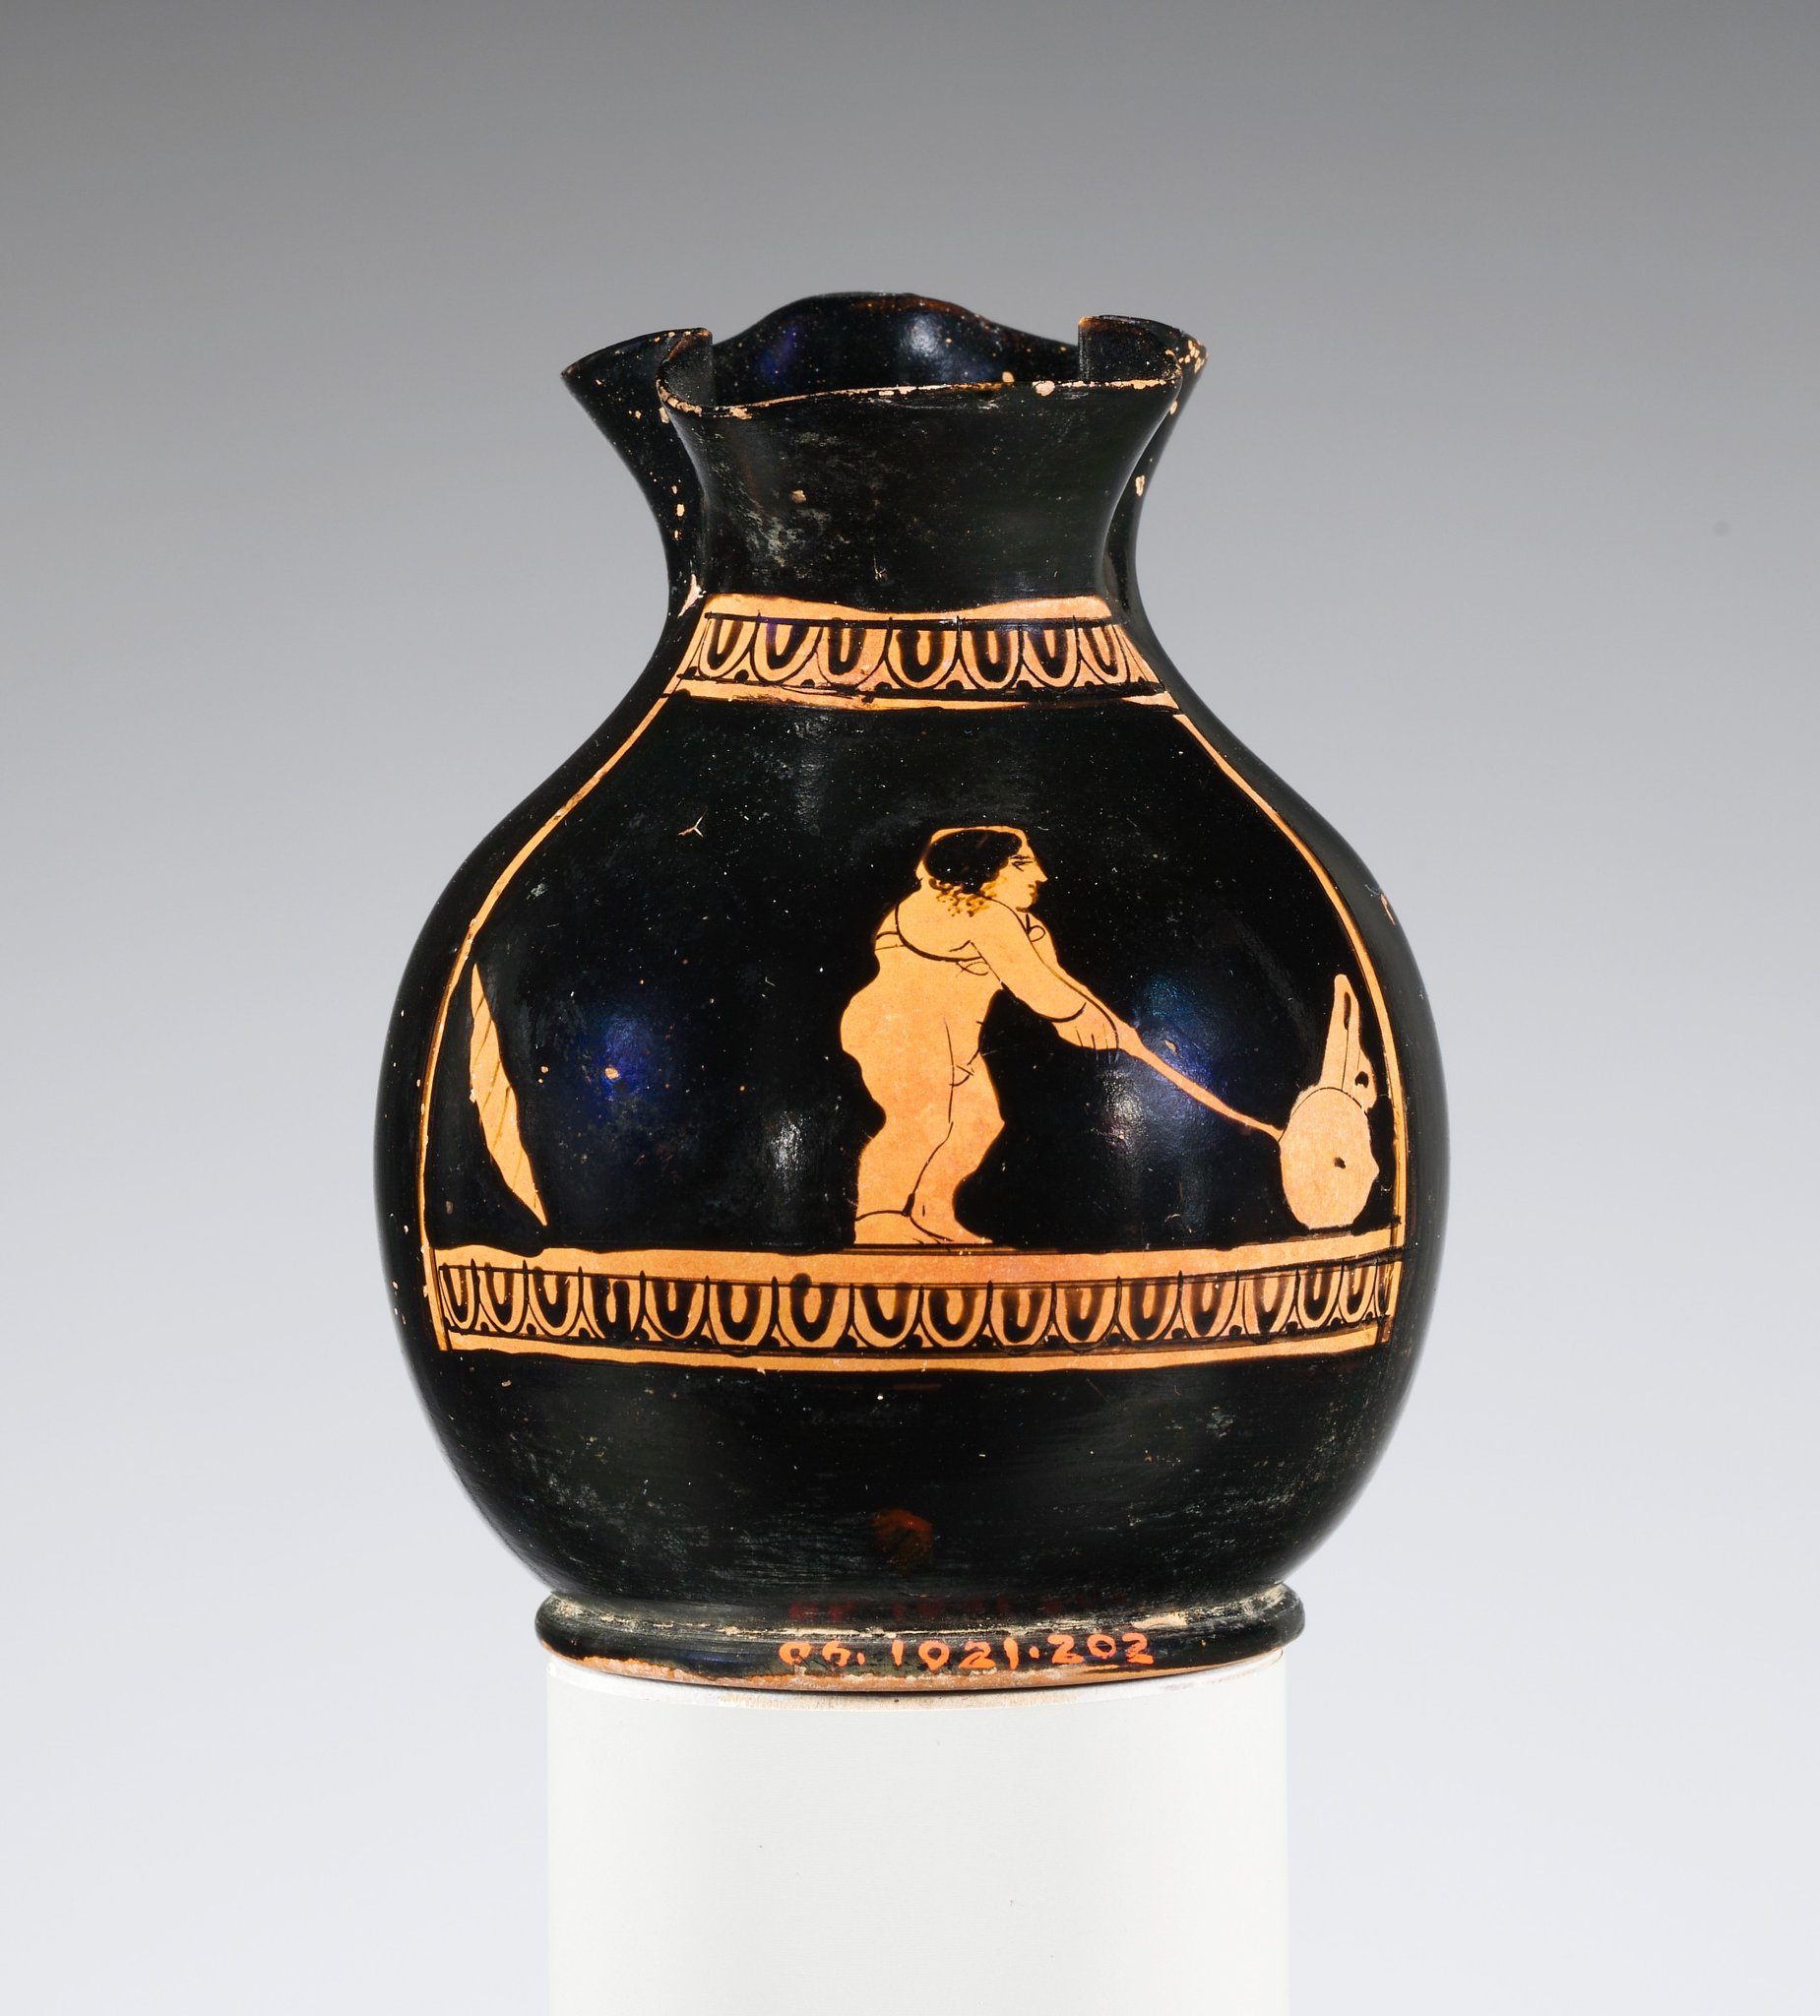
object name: oinochoe, chou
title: Terracotta oinochoe: chous (jug)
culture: greek, attic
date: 420 BCE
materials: terracotta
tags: boys,toys